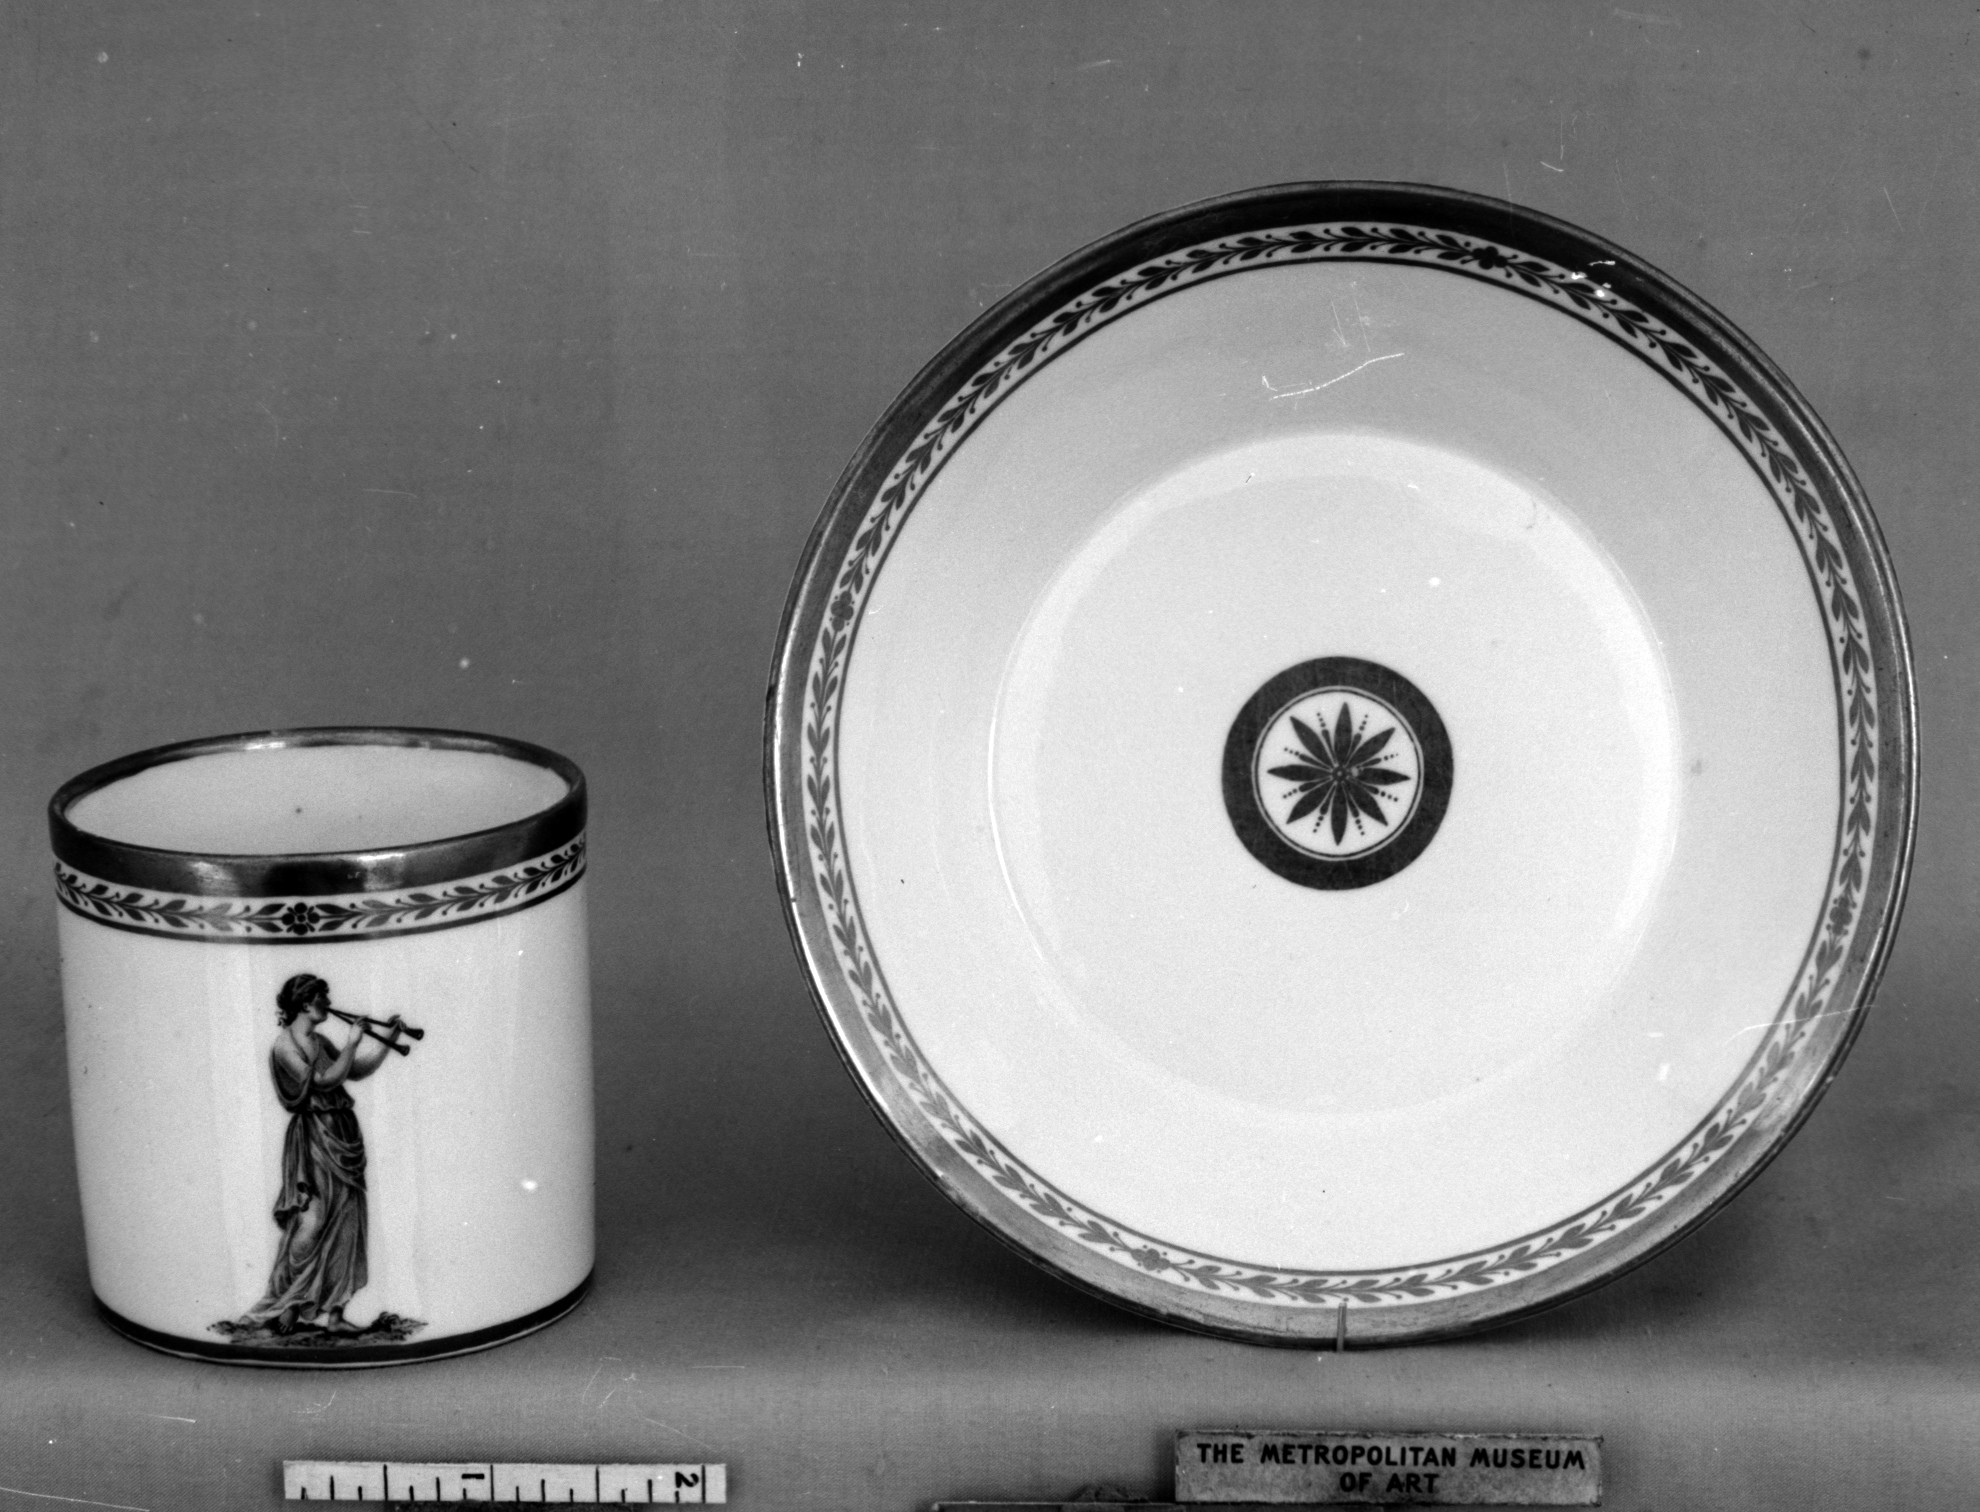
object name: saucer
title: Saucer (part of a coffee service)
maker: nymphenburg porcelain manufactory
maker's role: manufactory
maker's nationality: german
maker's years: 1747-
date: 1801-1833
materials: hard paste porcelain